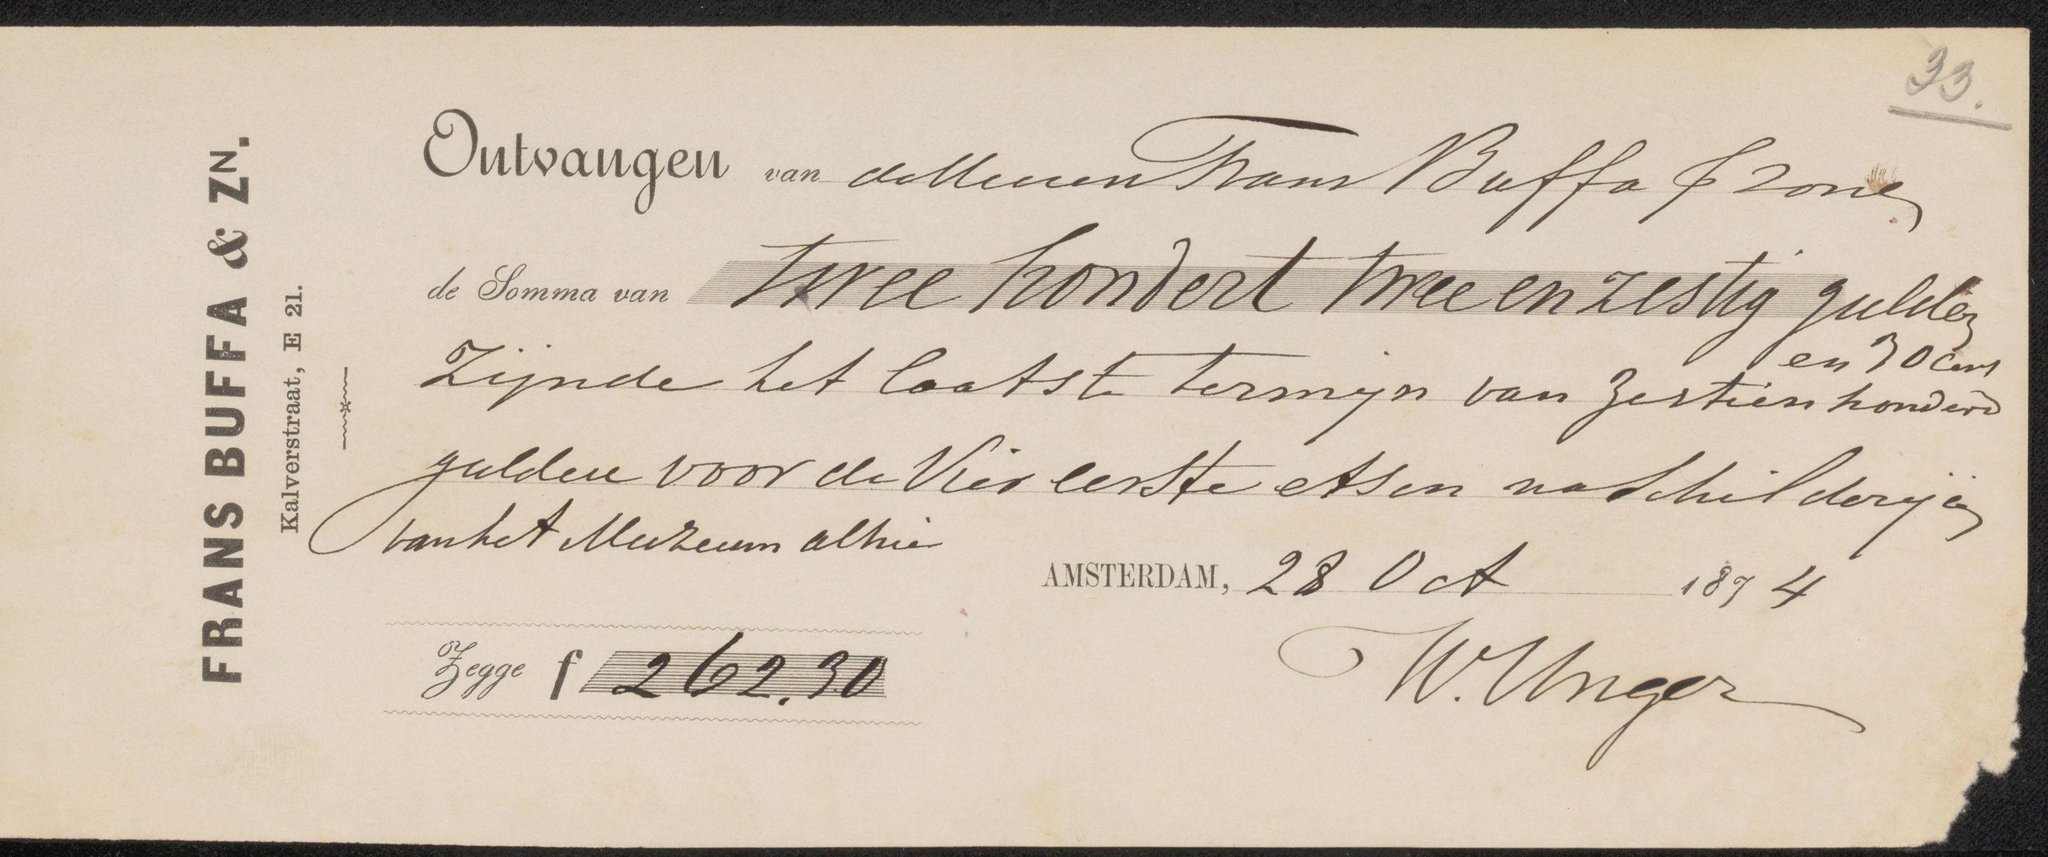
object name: ontvangstbewijs, kwitantie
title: Kwitantie voor William Unger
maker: william unger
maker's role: draughtsman, painter, print maker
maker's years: 1837-1932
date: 1874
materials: ink, paper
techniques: pen, printing, writing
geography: amsterdam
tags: the graphic arts, money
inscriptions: collector's mark: Lugt 2233